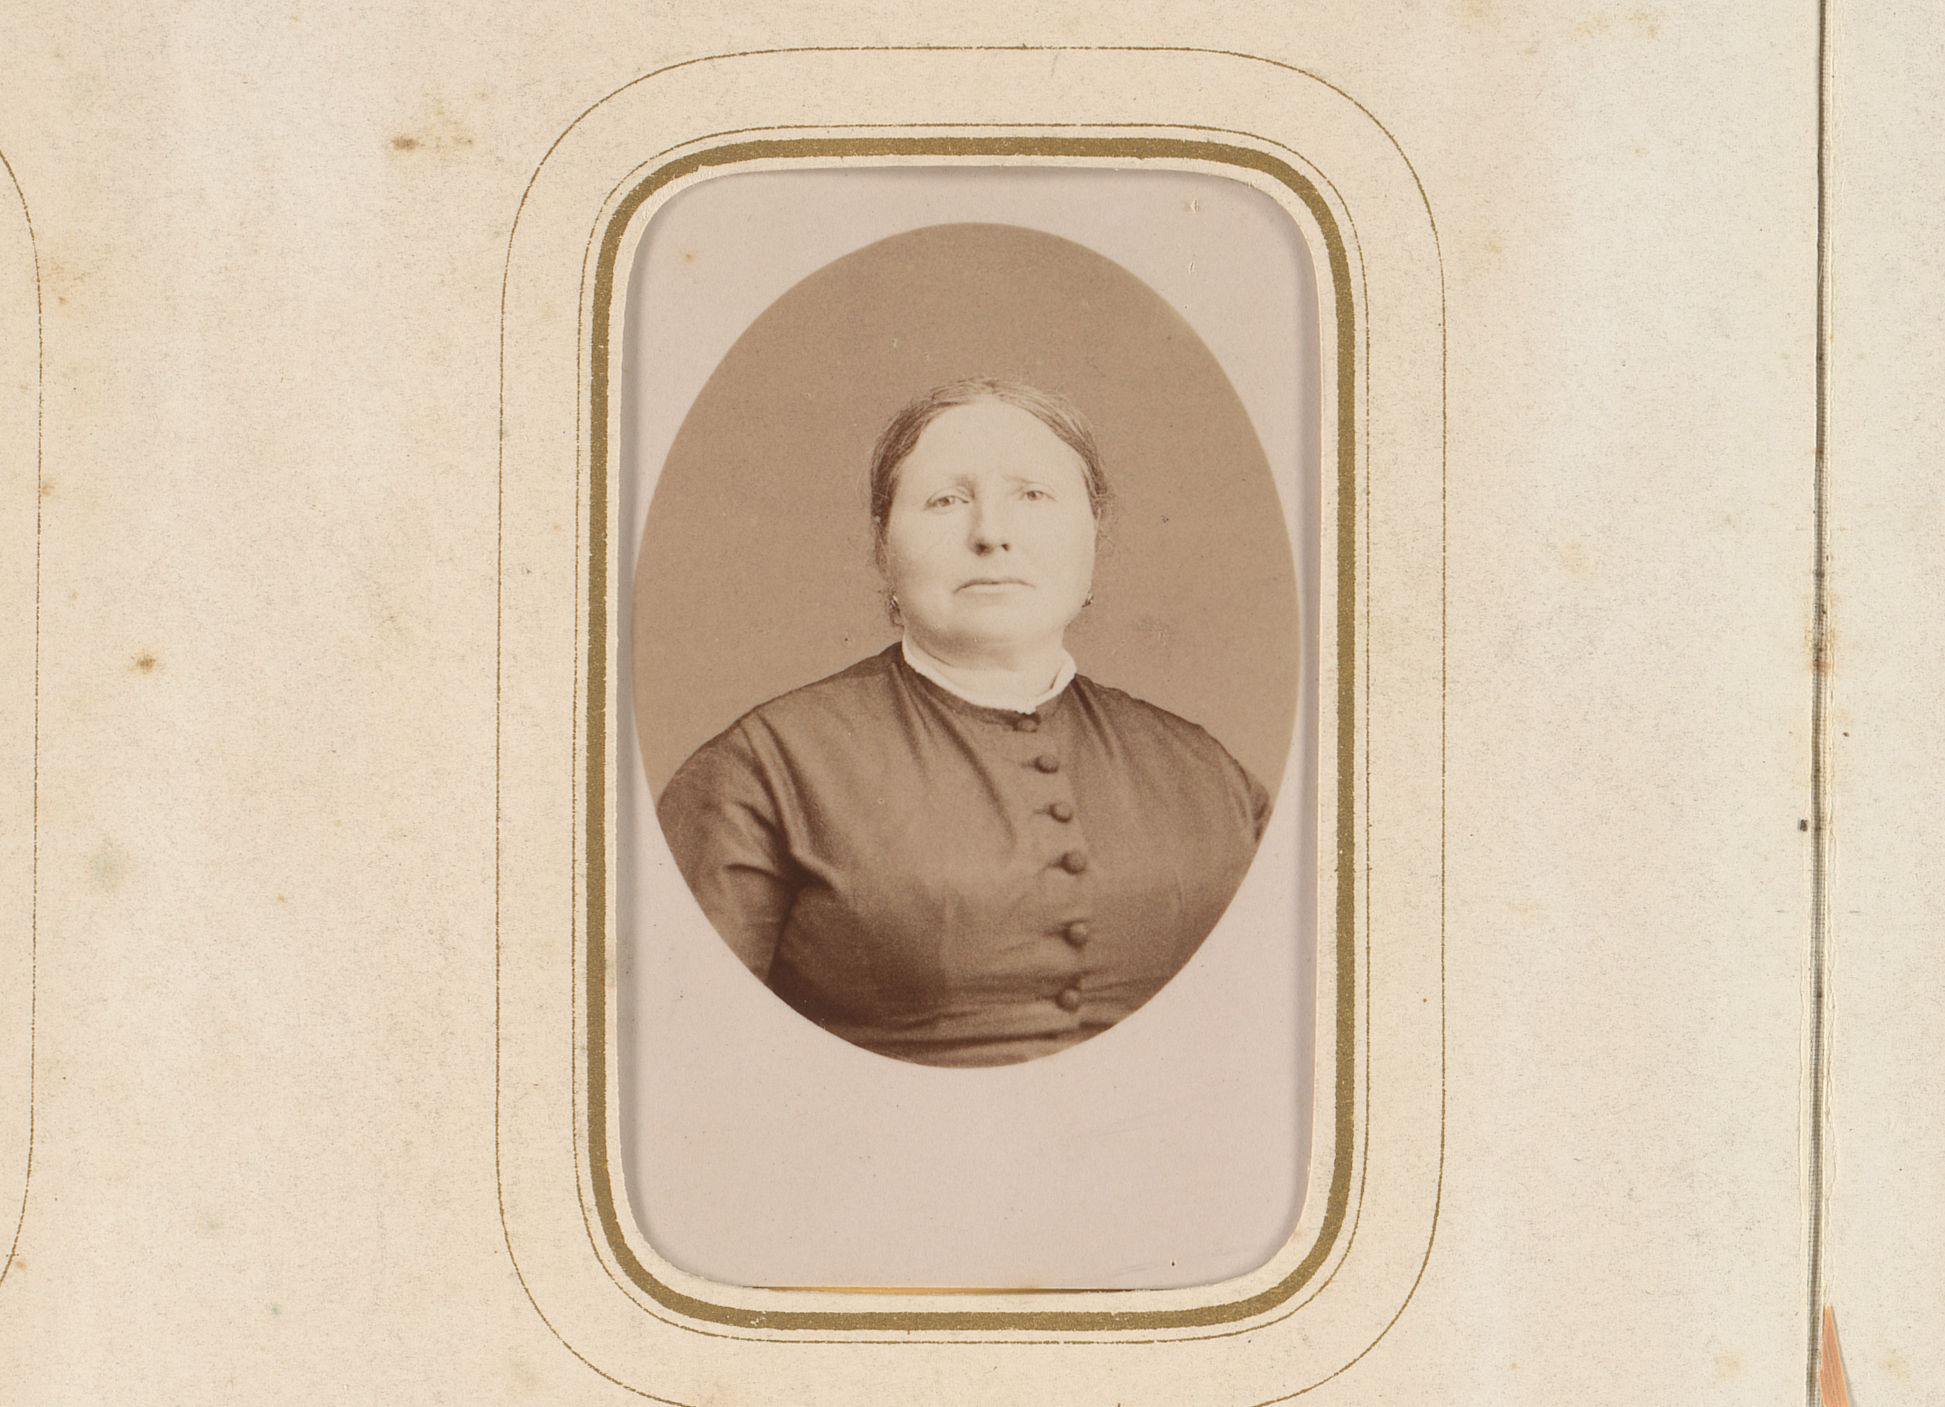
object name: photograph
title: Portret van een vrouw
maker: a. boyer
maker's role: fotograaf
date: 1880-1900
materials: cardboard, celluloid, photographic support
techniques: albumen print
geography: malakoff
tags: historical persons - bb - woman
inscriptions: inscription: ‘Photographie de Malakoff/ rue Béranger, 16/ pres des ecoles/ A. Boyer/ réproductions & agrandissements’